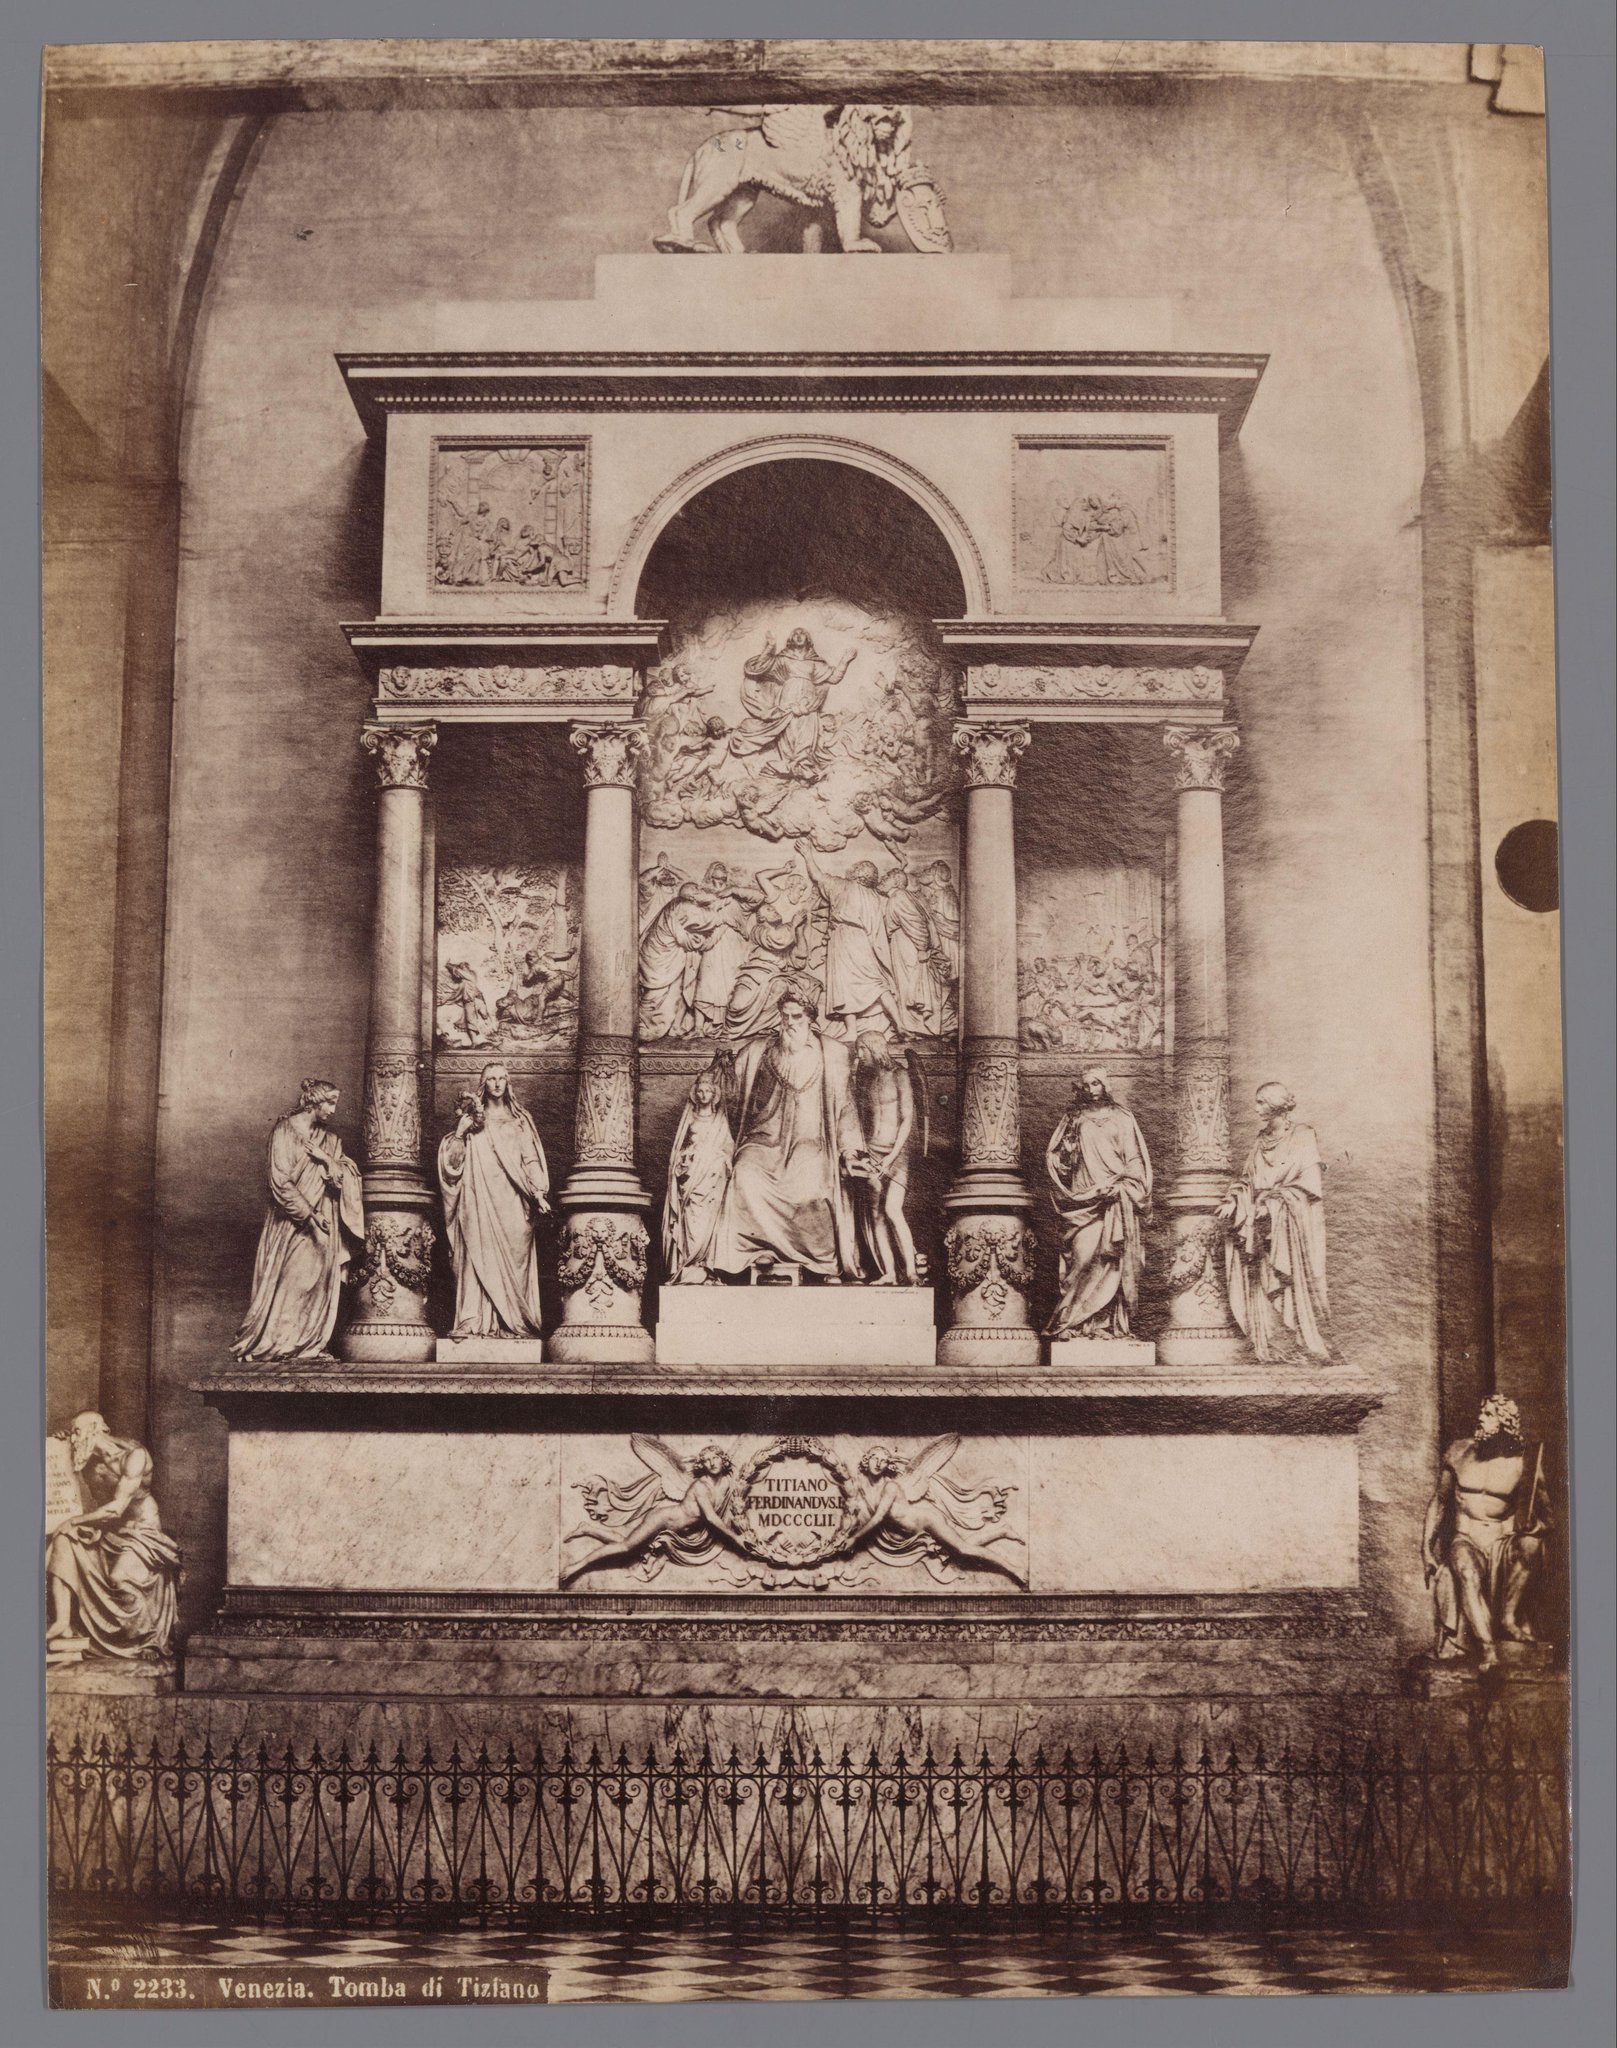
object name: photograph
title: Venezia. Tomba di Tiziano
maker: Anonymous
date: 1851-1900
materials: paper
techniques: albumen print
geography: venice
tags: venice, painter, draughtsman, titiaan, grave-building, monumental tomb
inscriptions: number: ‘No. 2233.’